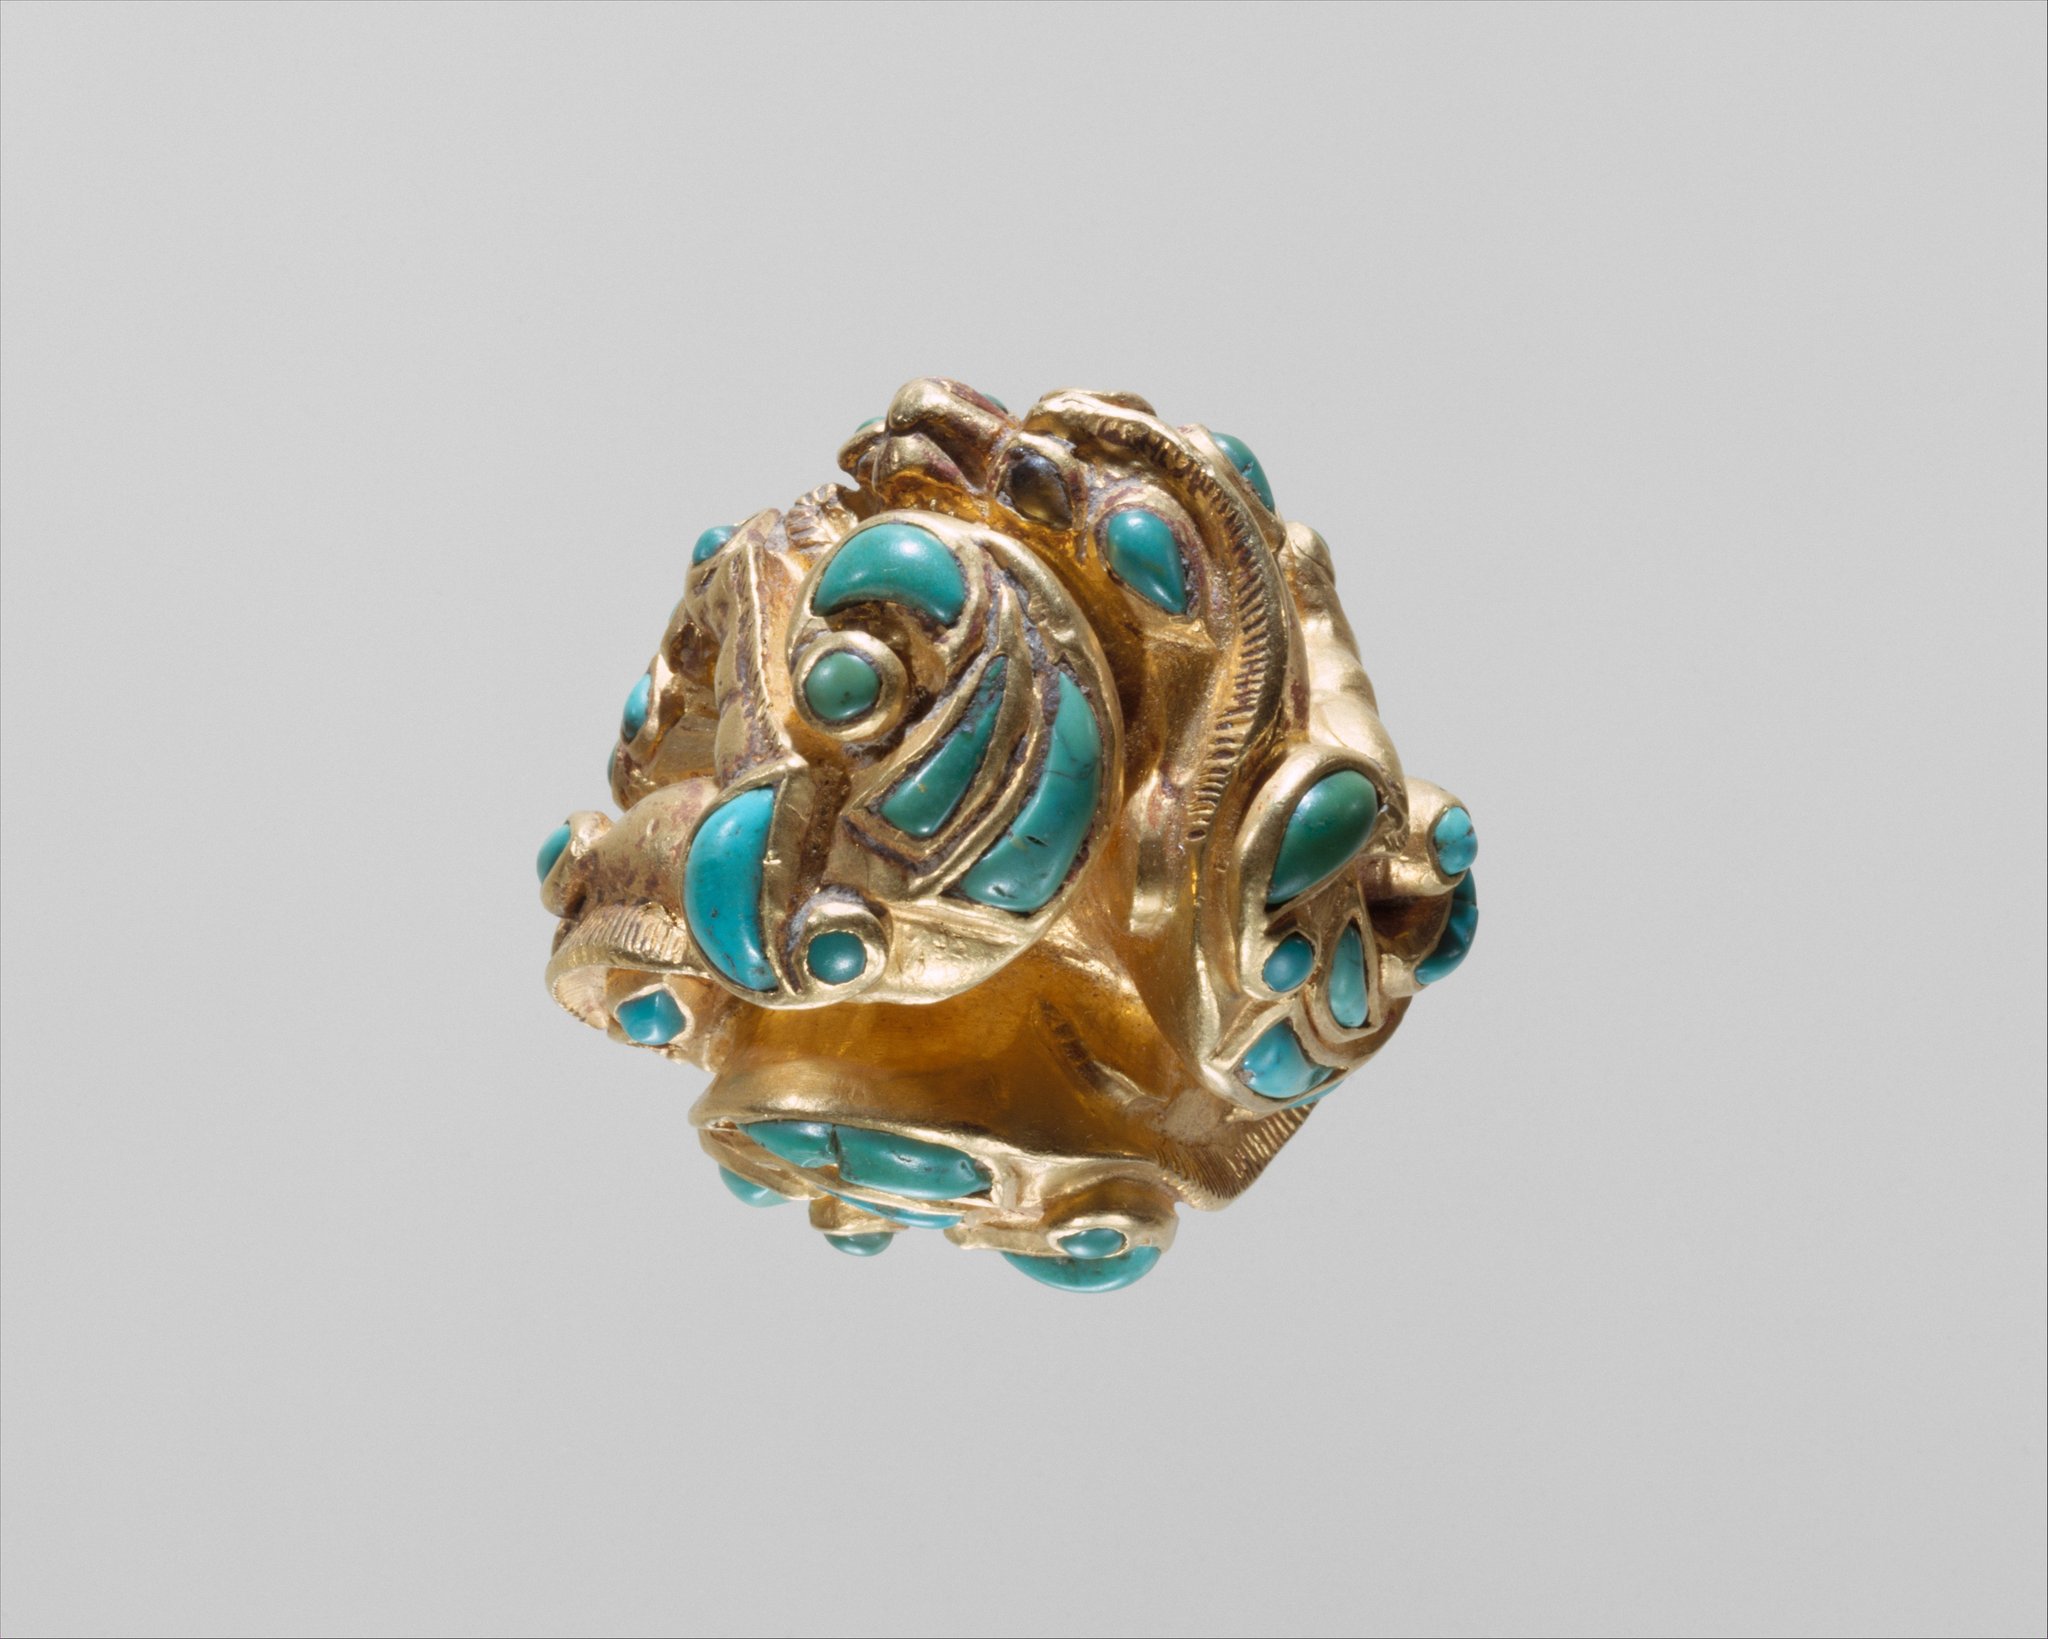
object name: pommel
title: Pommel in the shape of coiled animals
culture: sarmatian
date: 300-1 BCE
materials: gold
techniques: inlay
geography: eurasian steppes